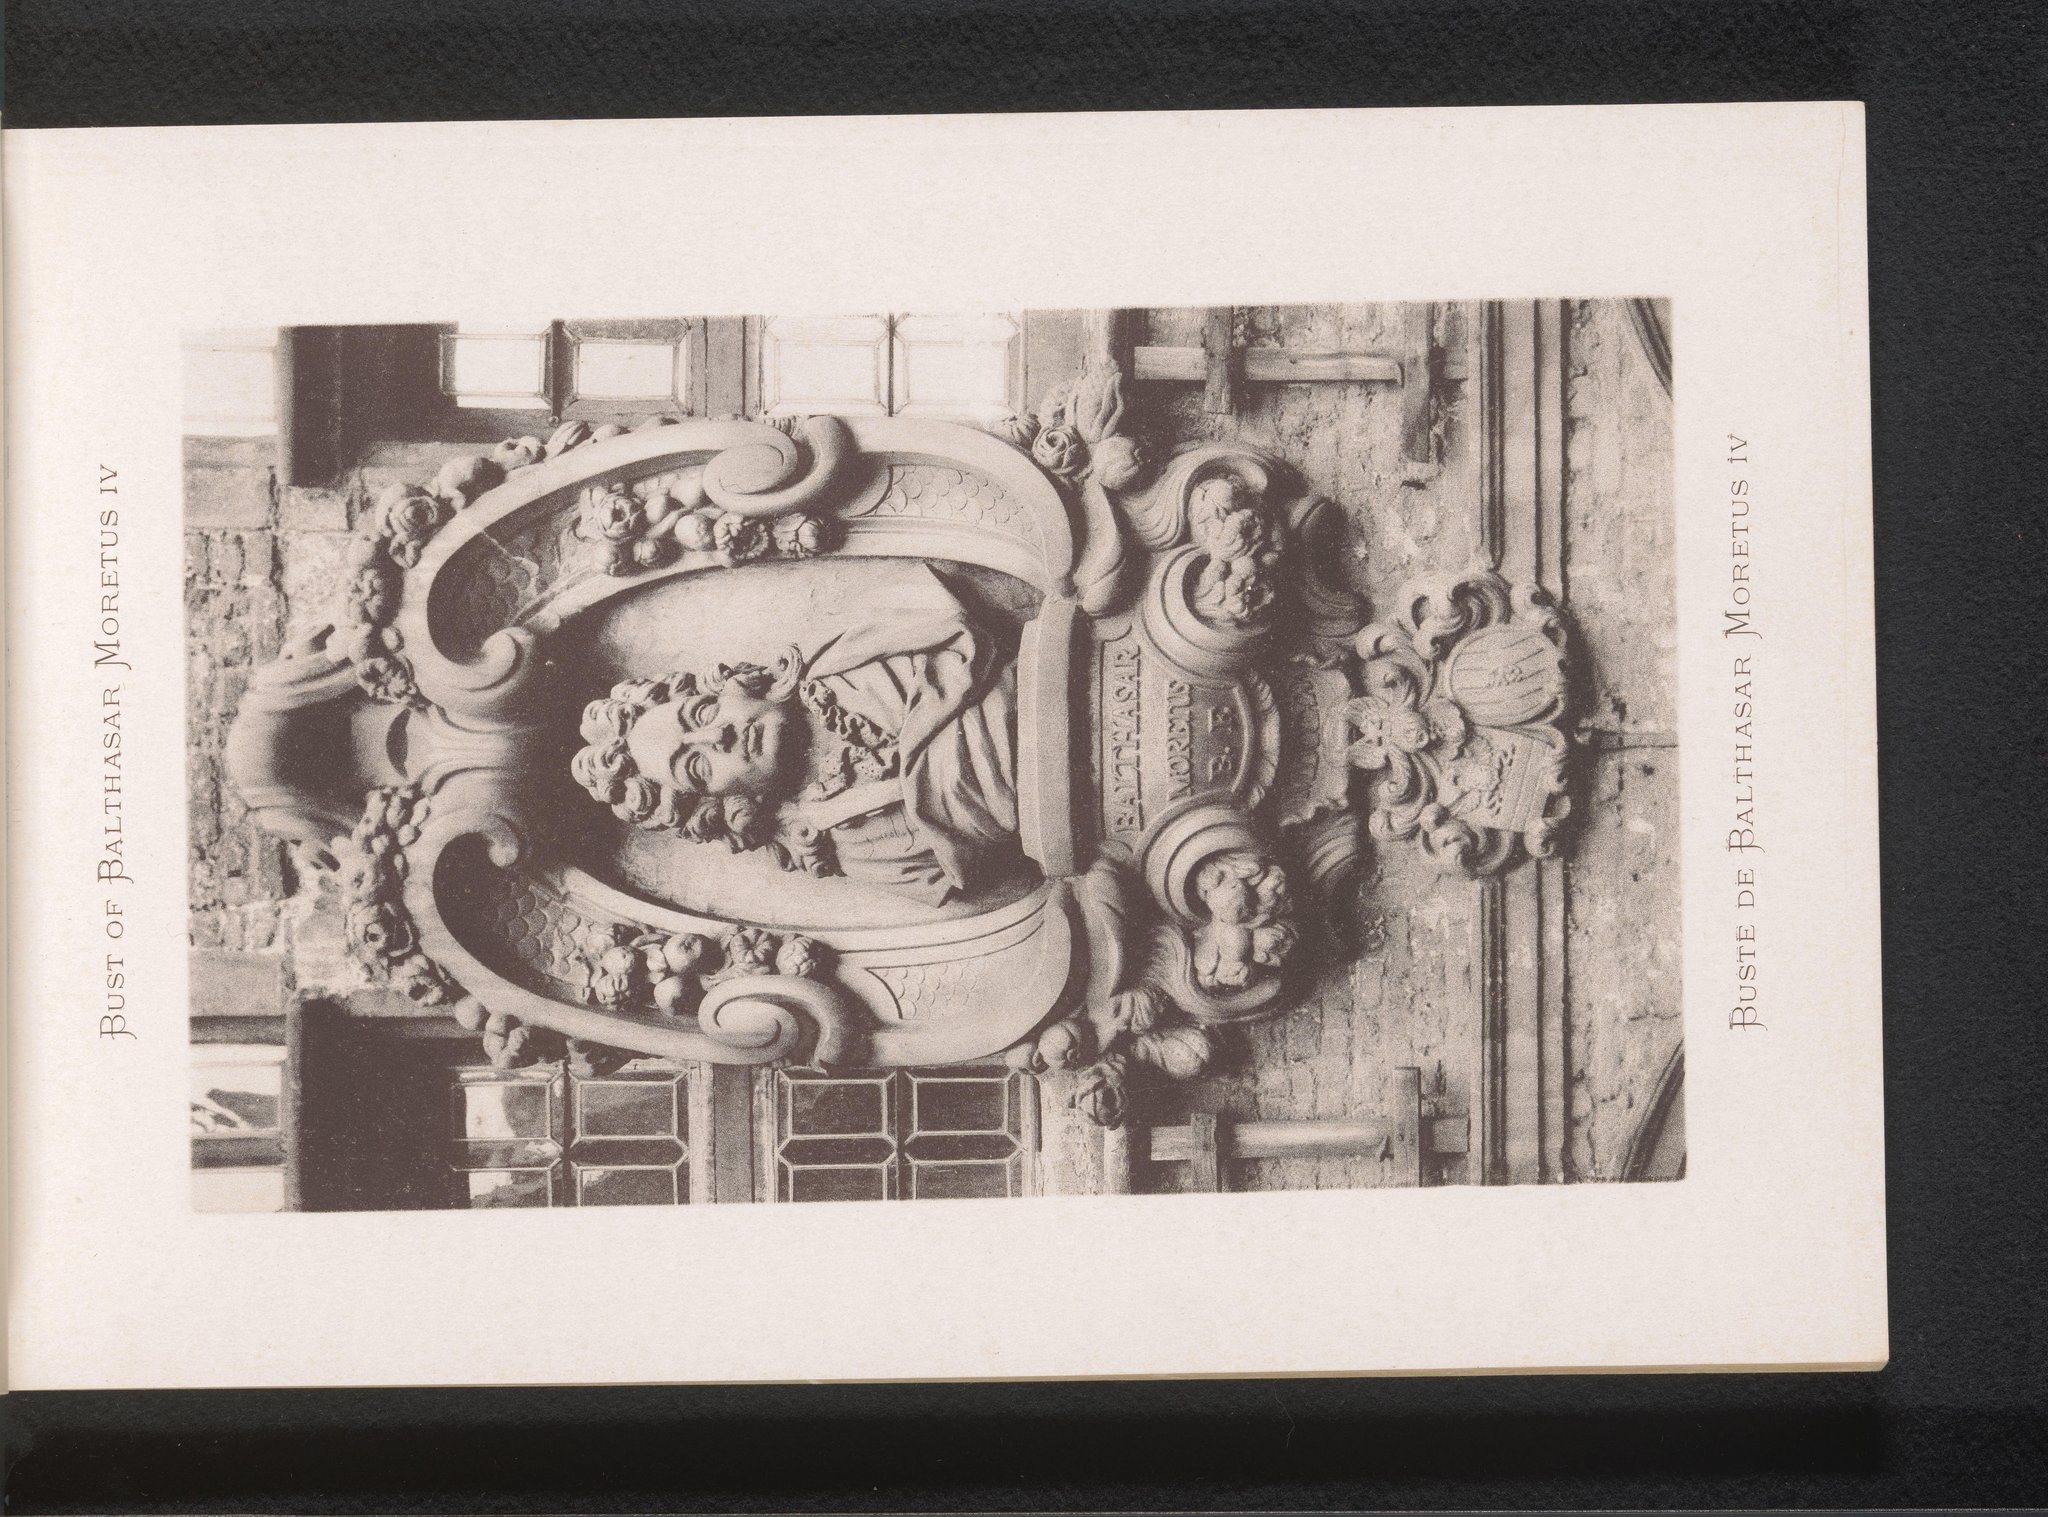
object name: page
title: Buste de Balthasar Moretus IV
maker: Anonymous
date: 1892-1897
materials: paper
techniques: photograph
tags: chest, bust, sculpture